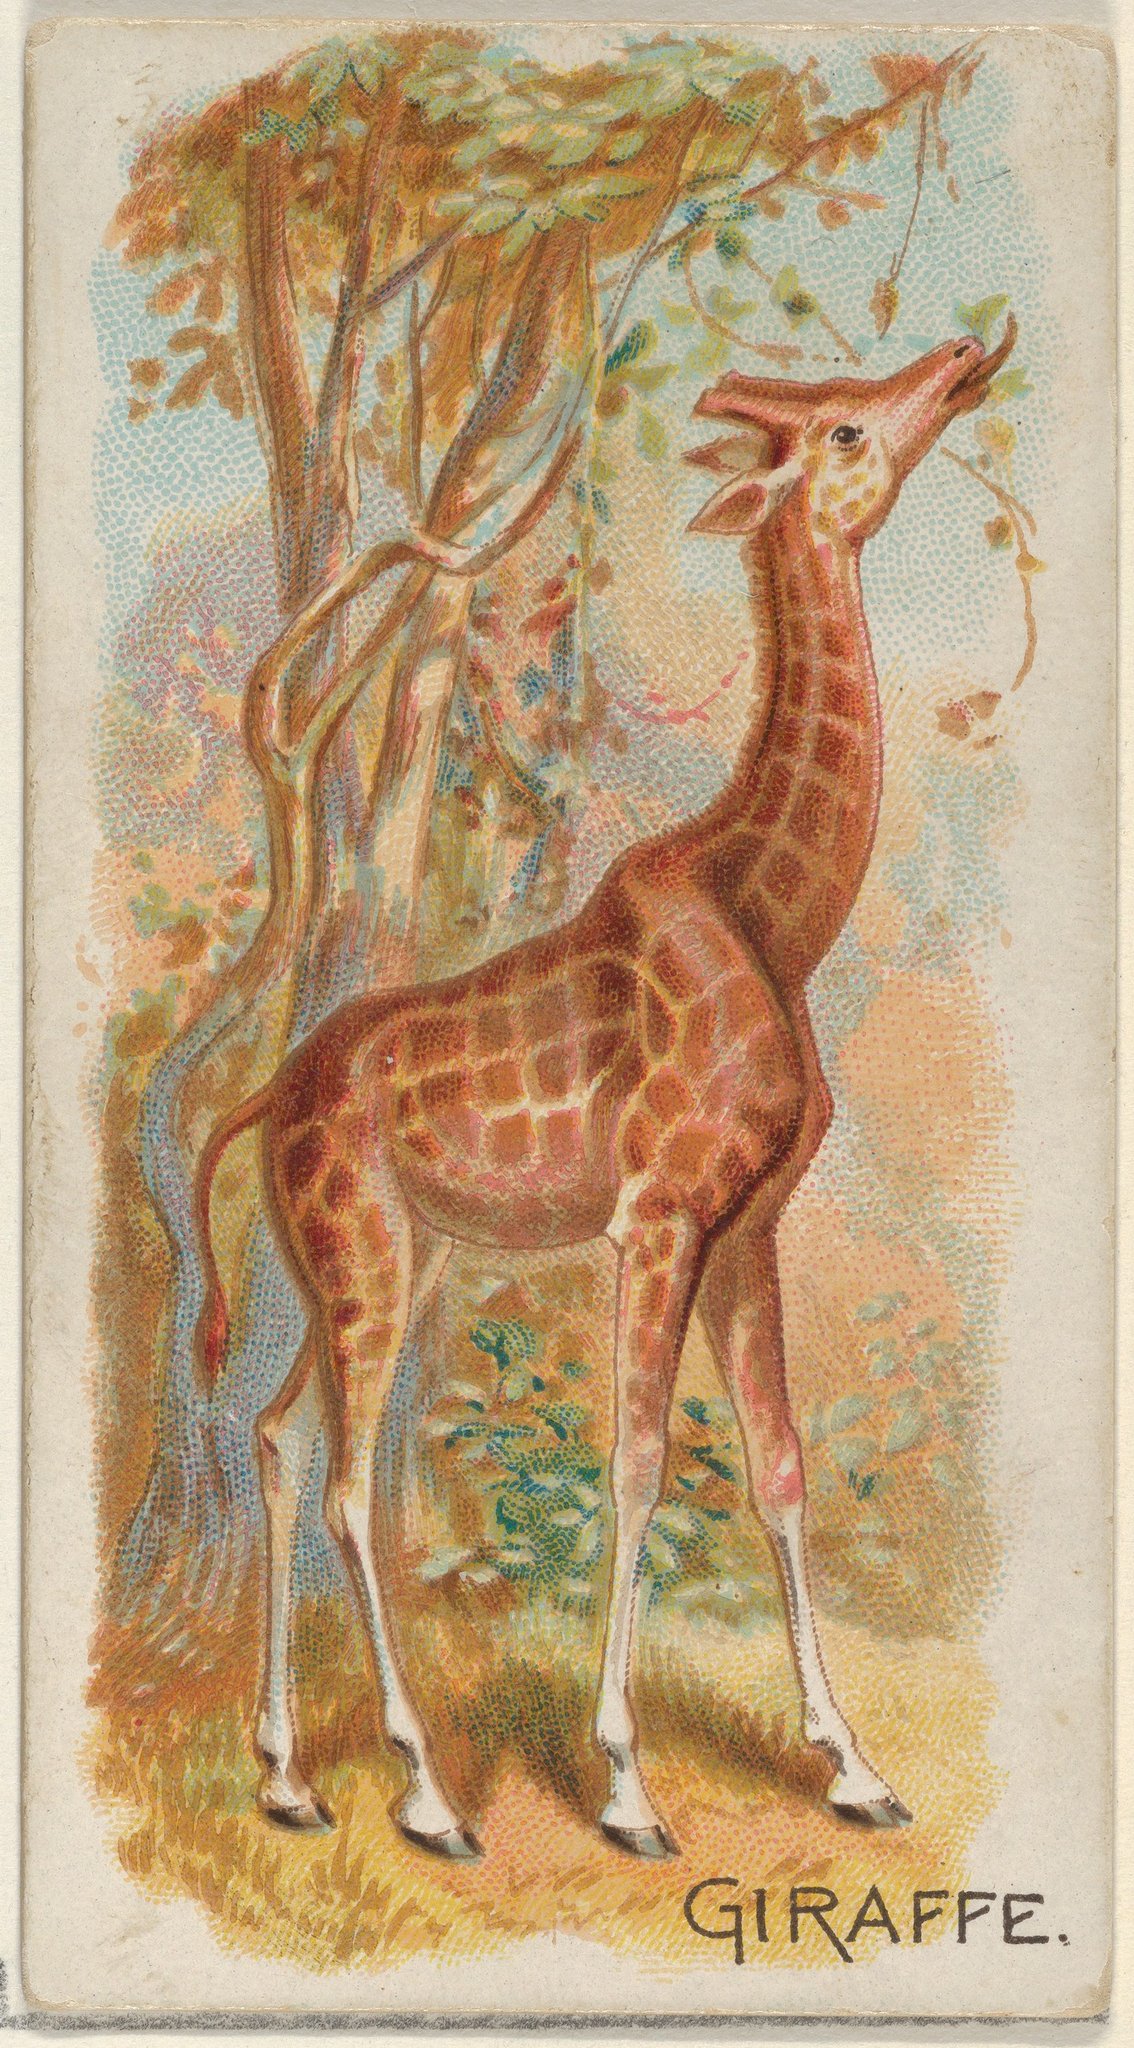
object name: print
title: Giraffe, from the Quadrupeds series (N21) for Allen & Ginter Cigarettes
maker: allen & ginter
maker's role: publisher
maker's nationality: american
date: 1890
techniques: color lithograph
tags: giraffes